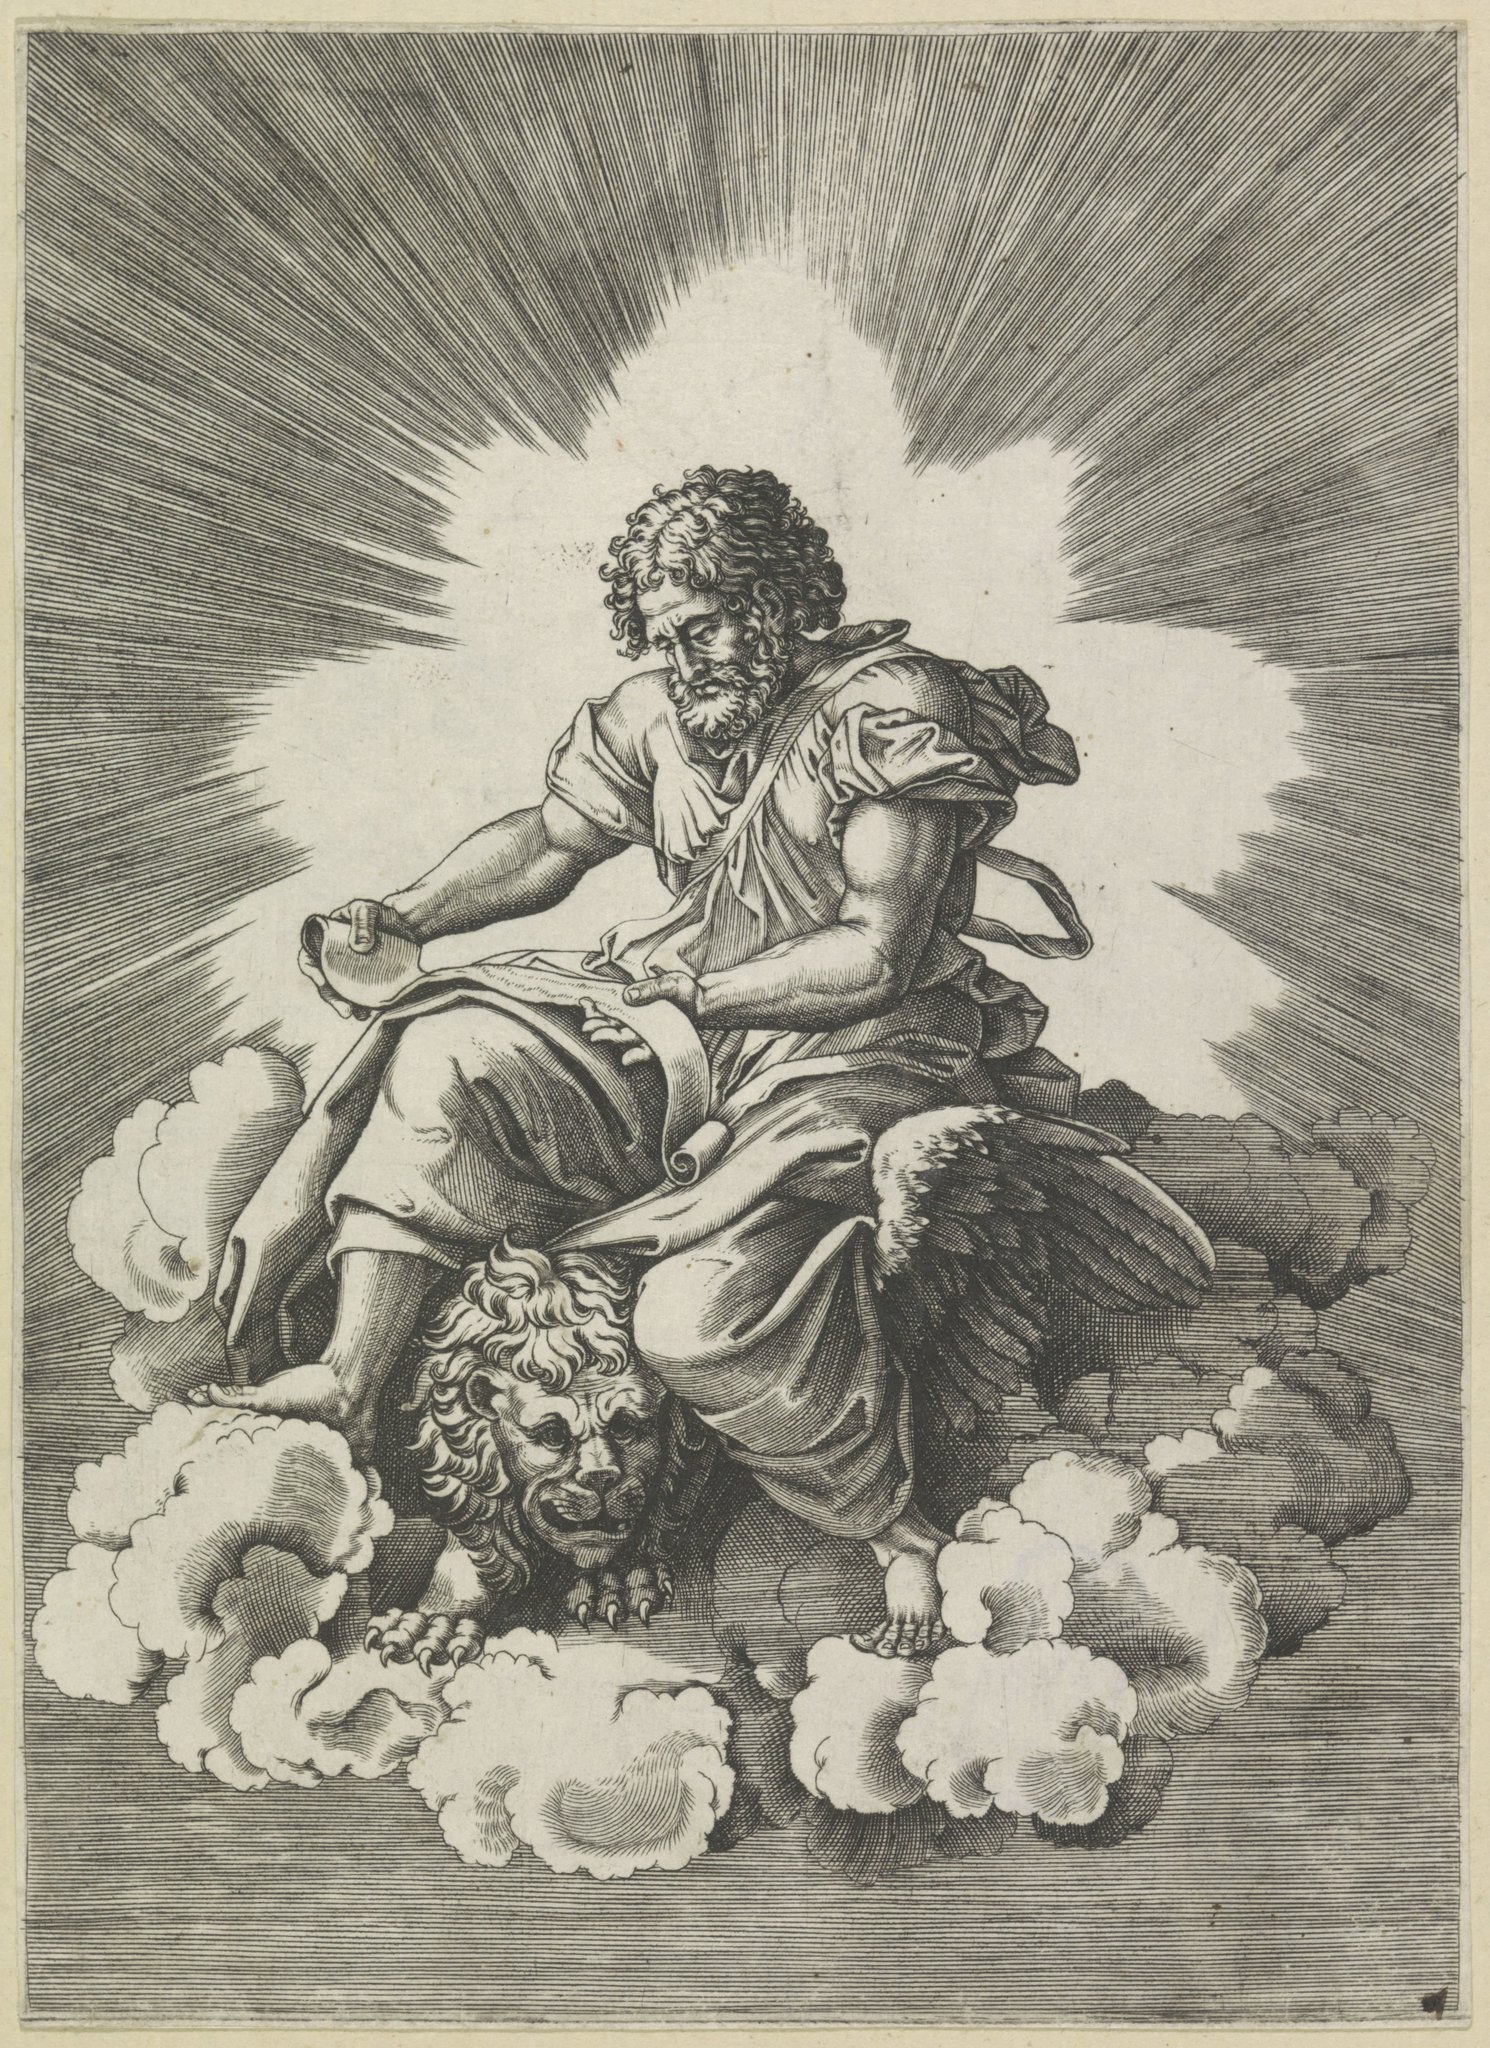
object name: print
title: De vier evangelisten (kopieën)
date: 1500-1536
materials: paper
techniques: engraving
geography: italy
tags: mark (marcus) the evangelist, and bishop of alexandria; possible attributes: book, (winged) lion, pen and inkhorn, scroll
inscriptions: collector's mark: Lugt 10, number, collector's mark: Lugt 11, collector's mark: ‘Hinloopen’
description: Deze prent maakt deel uit van een reeks van vier prenten. Spiegelbeeldige kopie naar een prent van Agostino Veneziano, naar ontwerp van Giulio Romano.